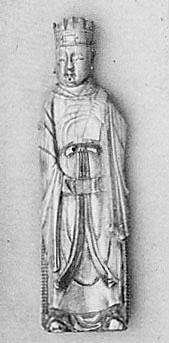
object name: figure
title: Carved Figure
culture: chinese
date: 1401-1500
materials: ivory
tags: men